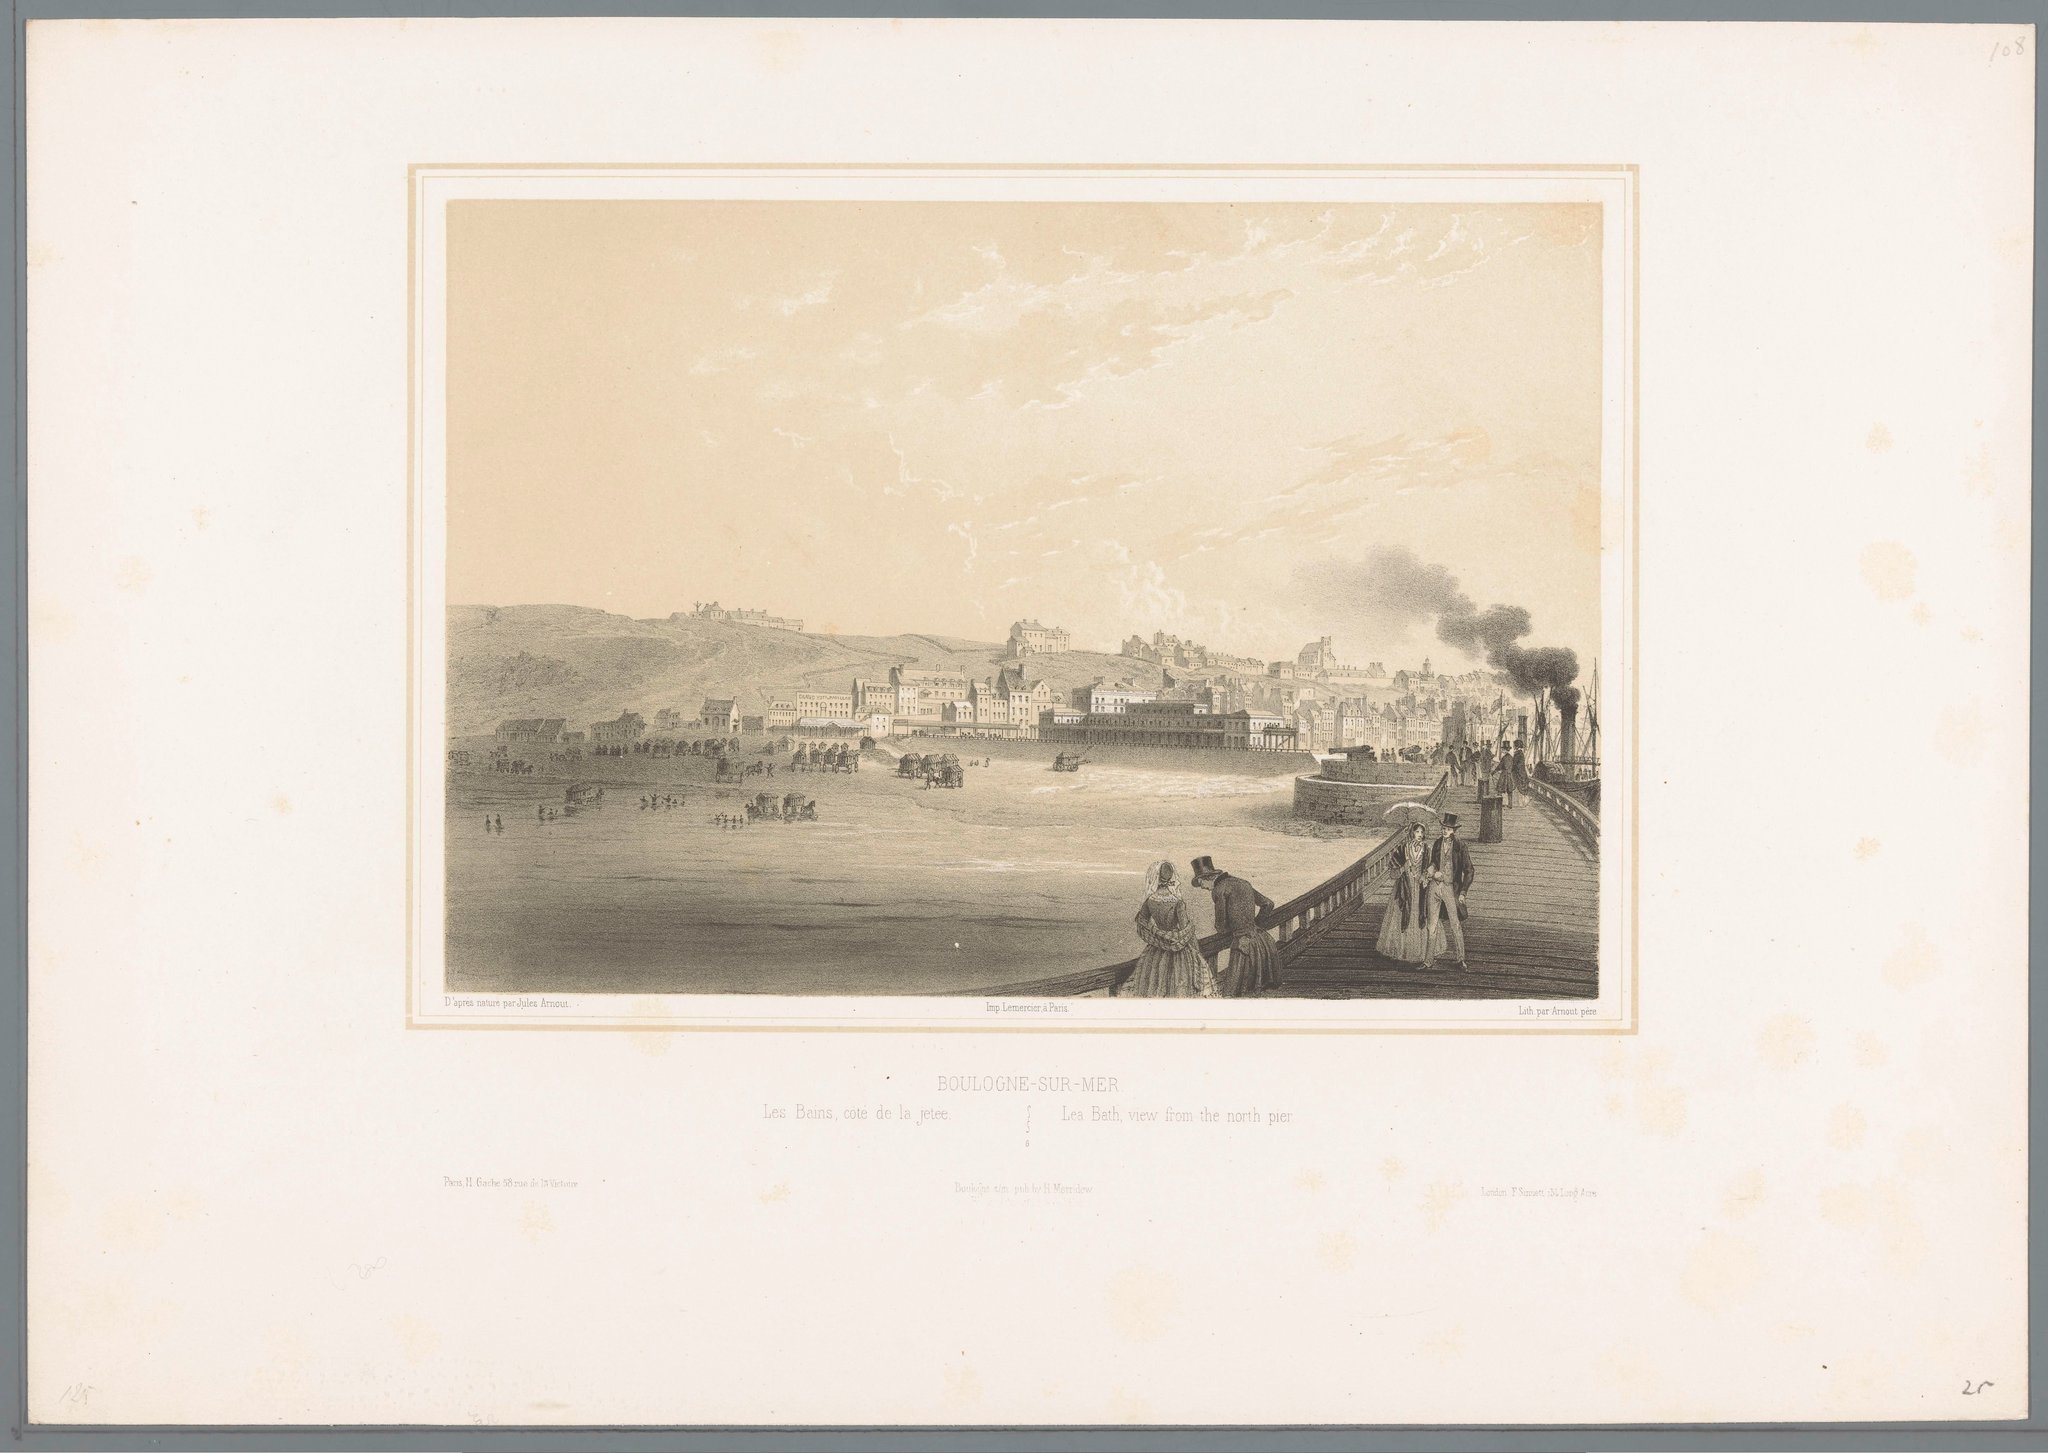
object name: print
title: Gezichten op Boulogne-sur-Mer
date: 1847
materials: paper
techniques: tone lithography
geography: paris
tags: beach (as place of recreation), prospect of village, silhouette of village, pier, quay, wharf, public baths - aa - in the open air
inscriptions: check stamp: Lugt 3977, number: ‘108 /1.25 /25’, collector's mark: Lugt 2228